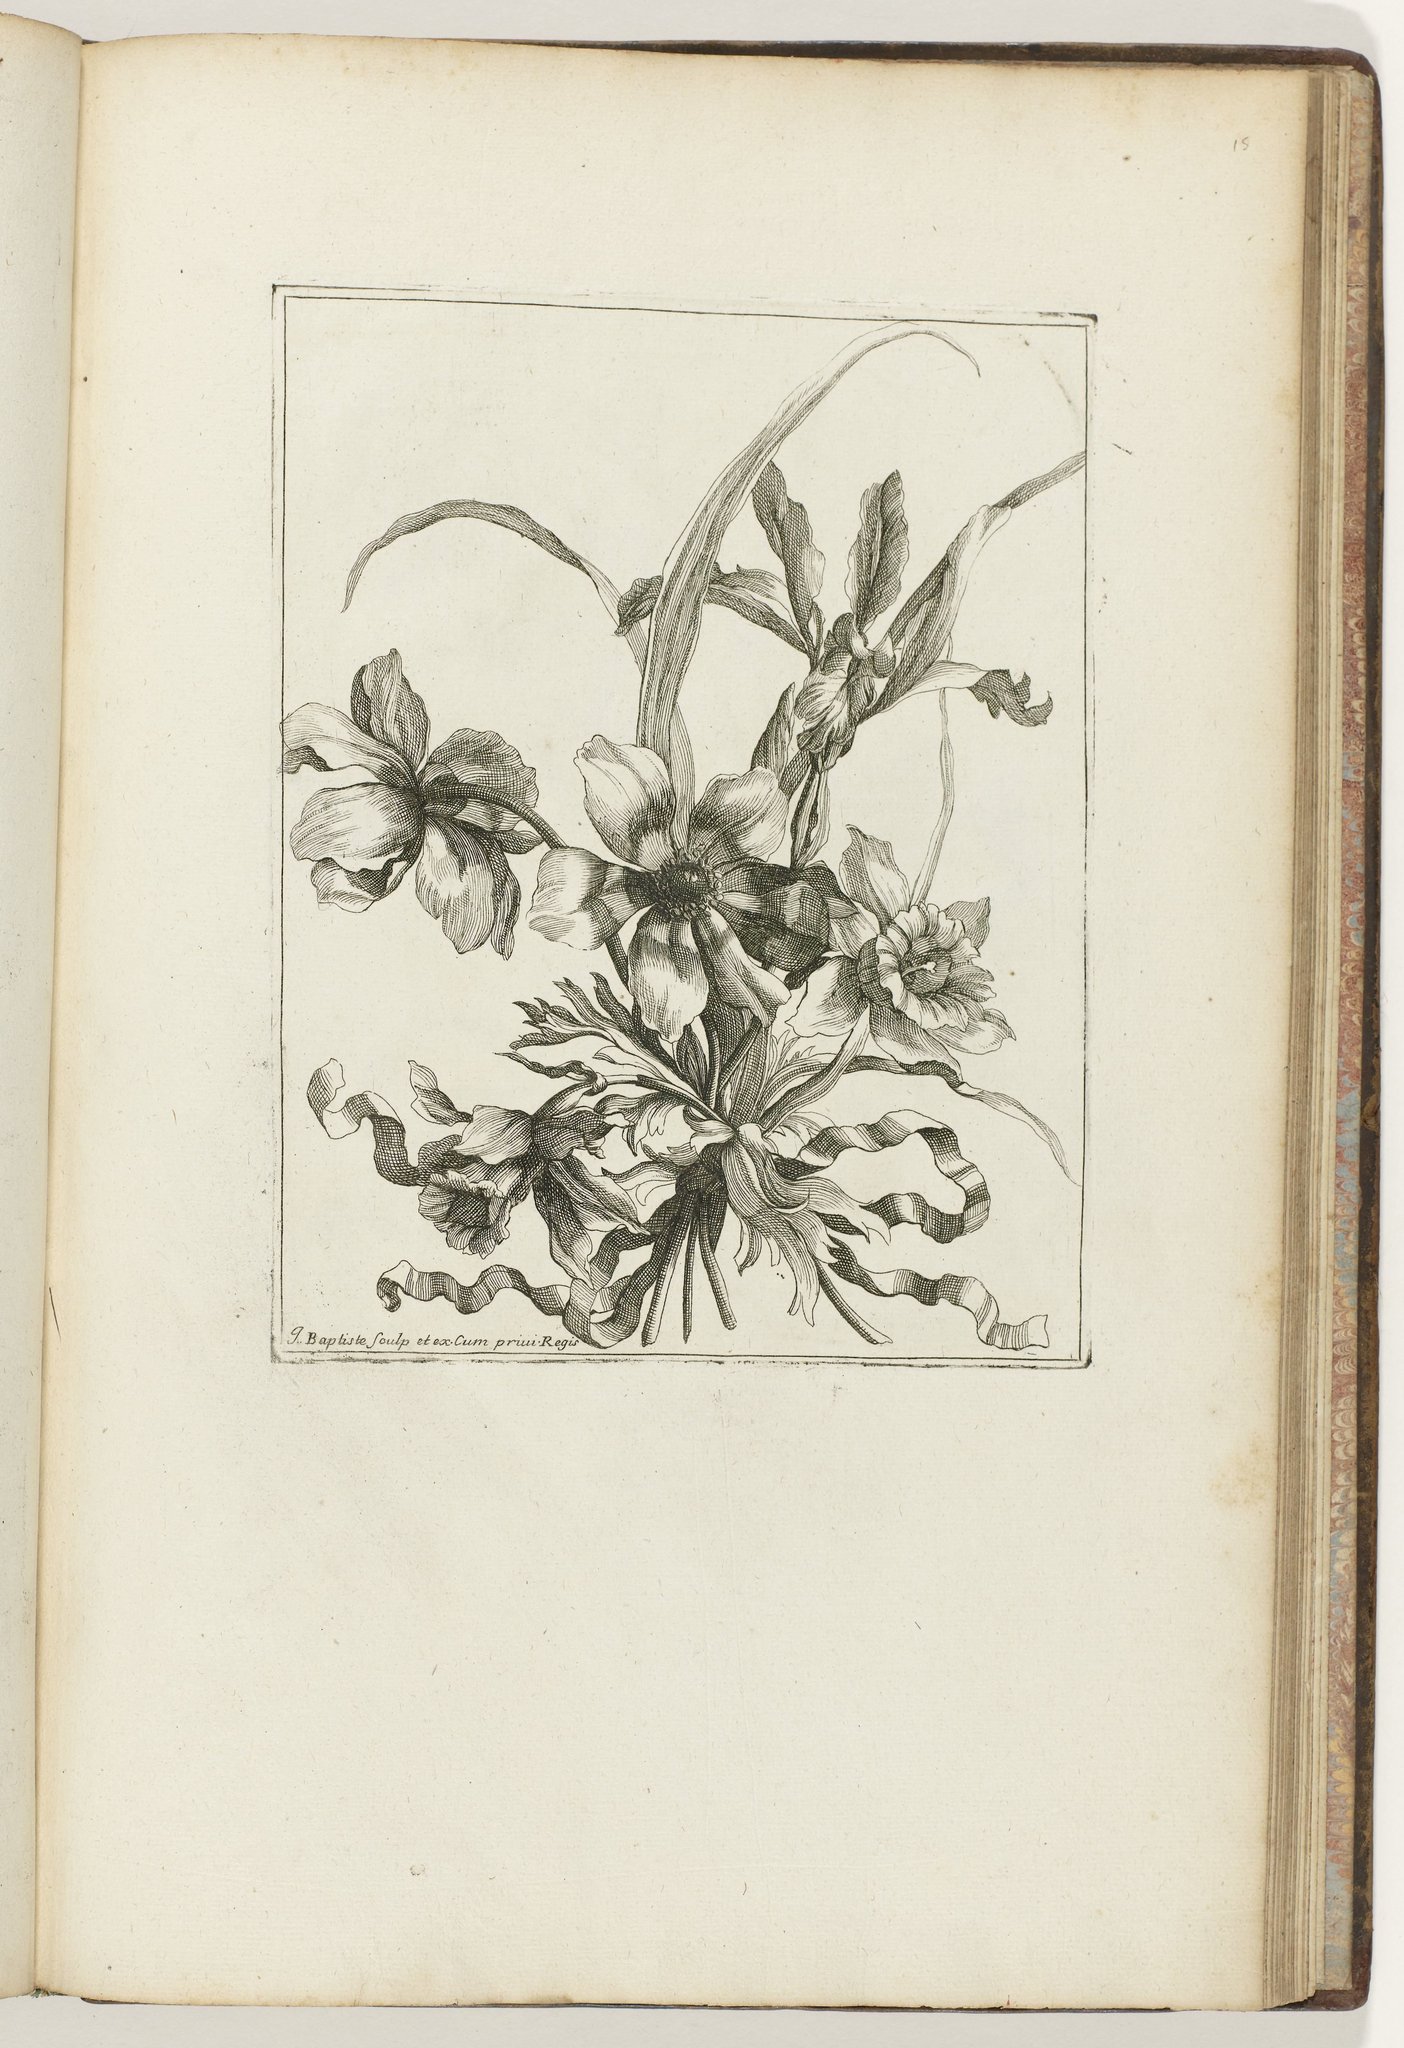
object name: album leaf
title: Les Petits Bouquets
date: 1680-1695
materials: paper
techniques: etching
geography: paris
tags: cut flowers; nosegay, bunch of flowers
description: Gebonden boeket. Prent maakt deel uit van een album.